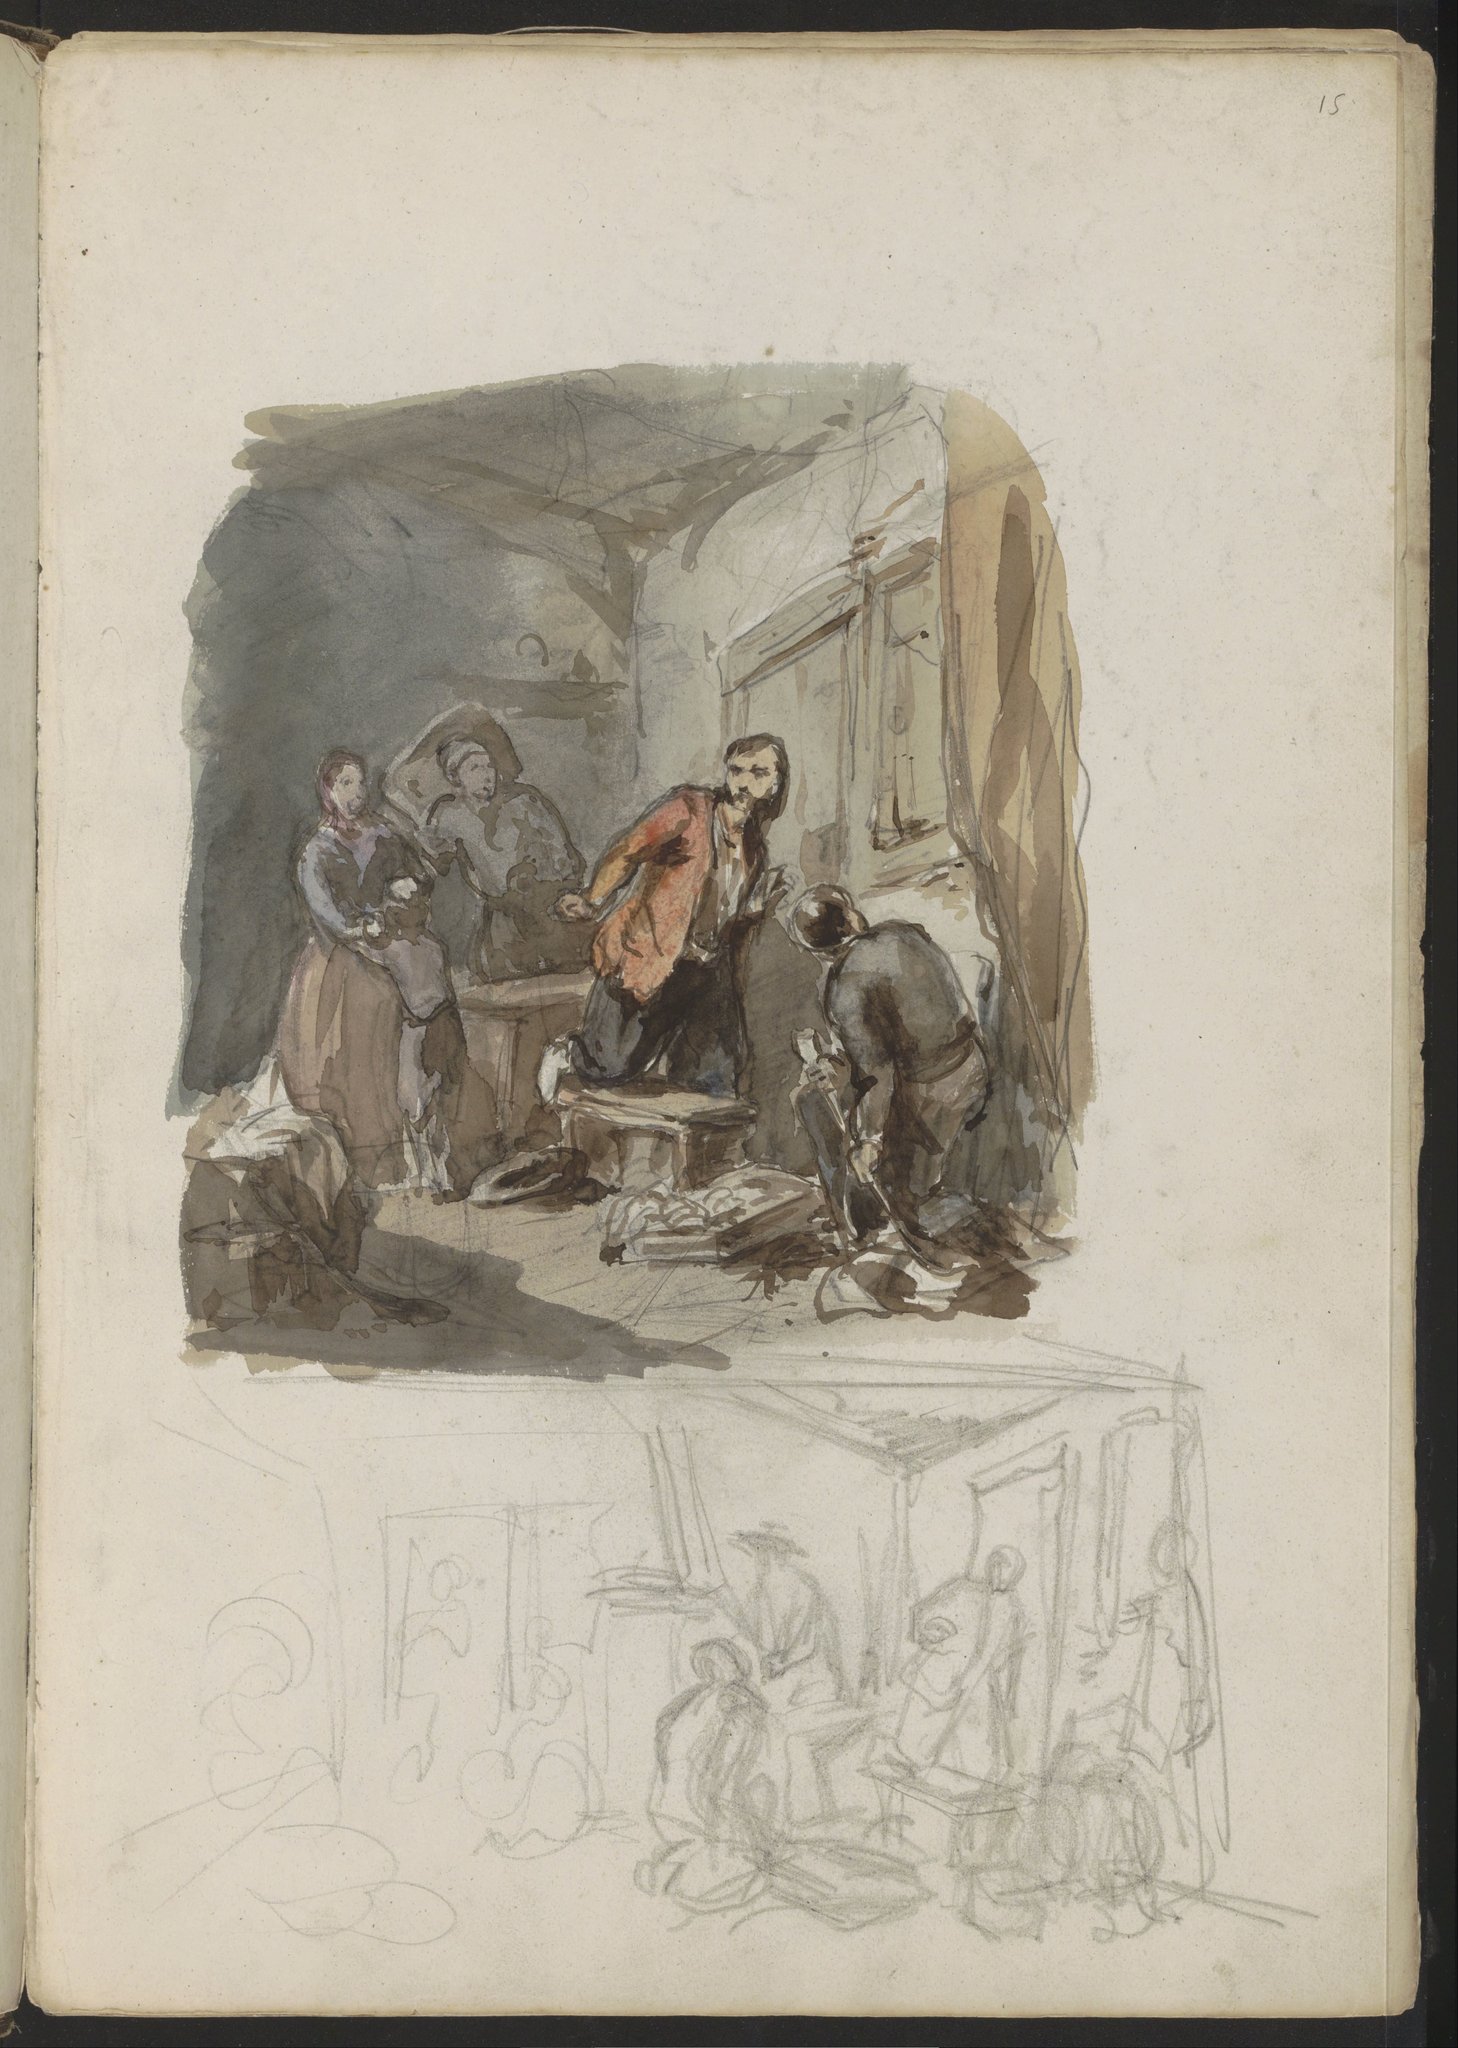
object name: sketchbook leaf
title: Interieur met figuren bij een venster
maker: johannes huybertus van hove bzn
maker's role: print maker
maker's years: 1827-1881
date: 1837-1881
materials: paper, pencil, watercolor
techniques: brush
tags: window shutters on the inside, interior of the house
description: Eén man in het gezelschap richt zich naar het venster, dat met luiken in afgesloten. Blad 15 recto uit een schetsboek met 33 bladen en 10 losse tekeningen.